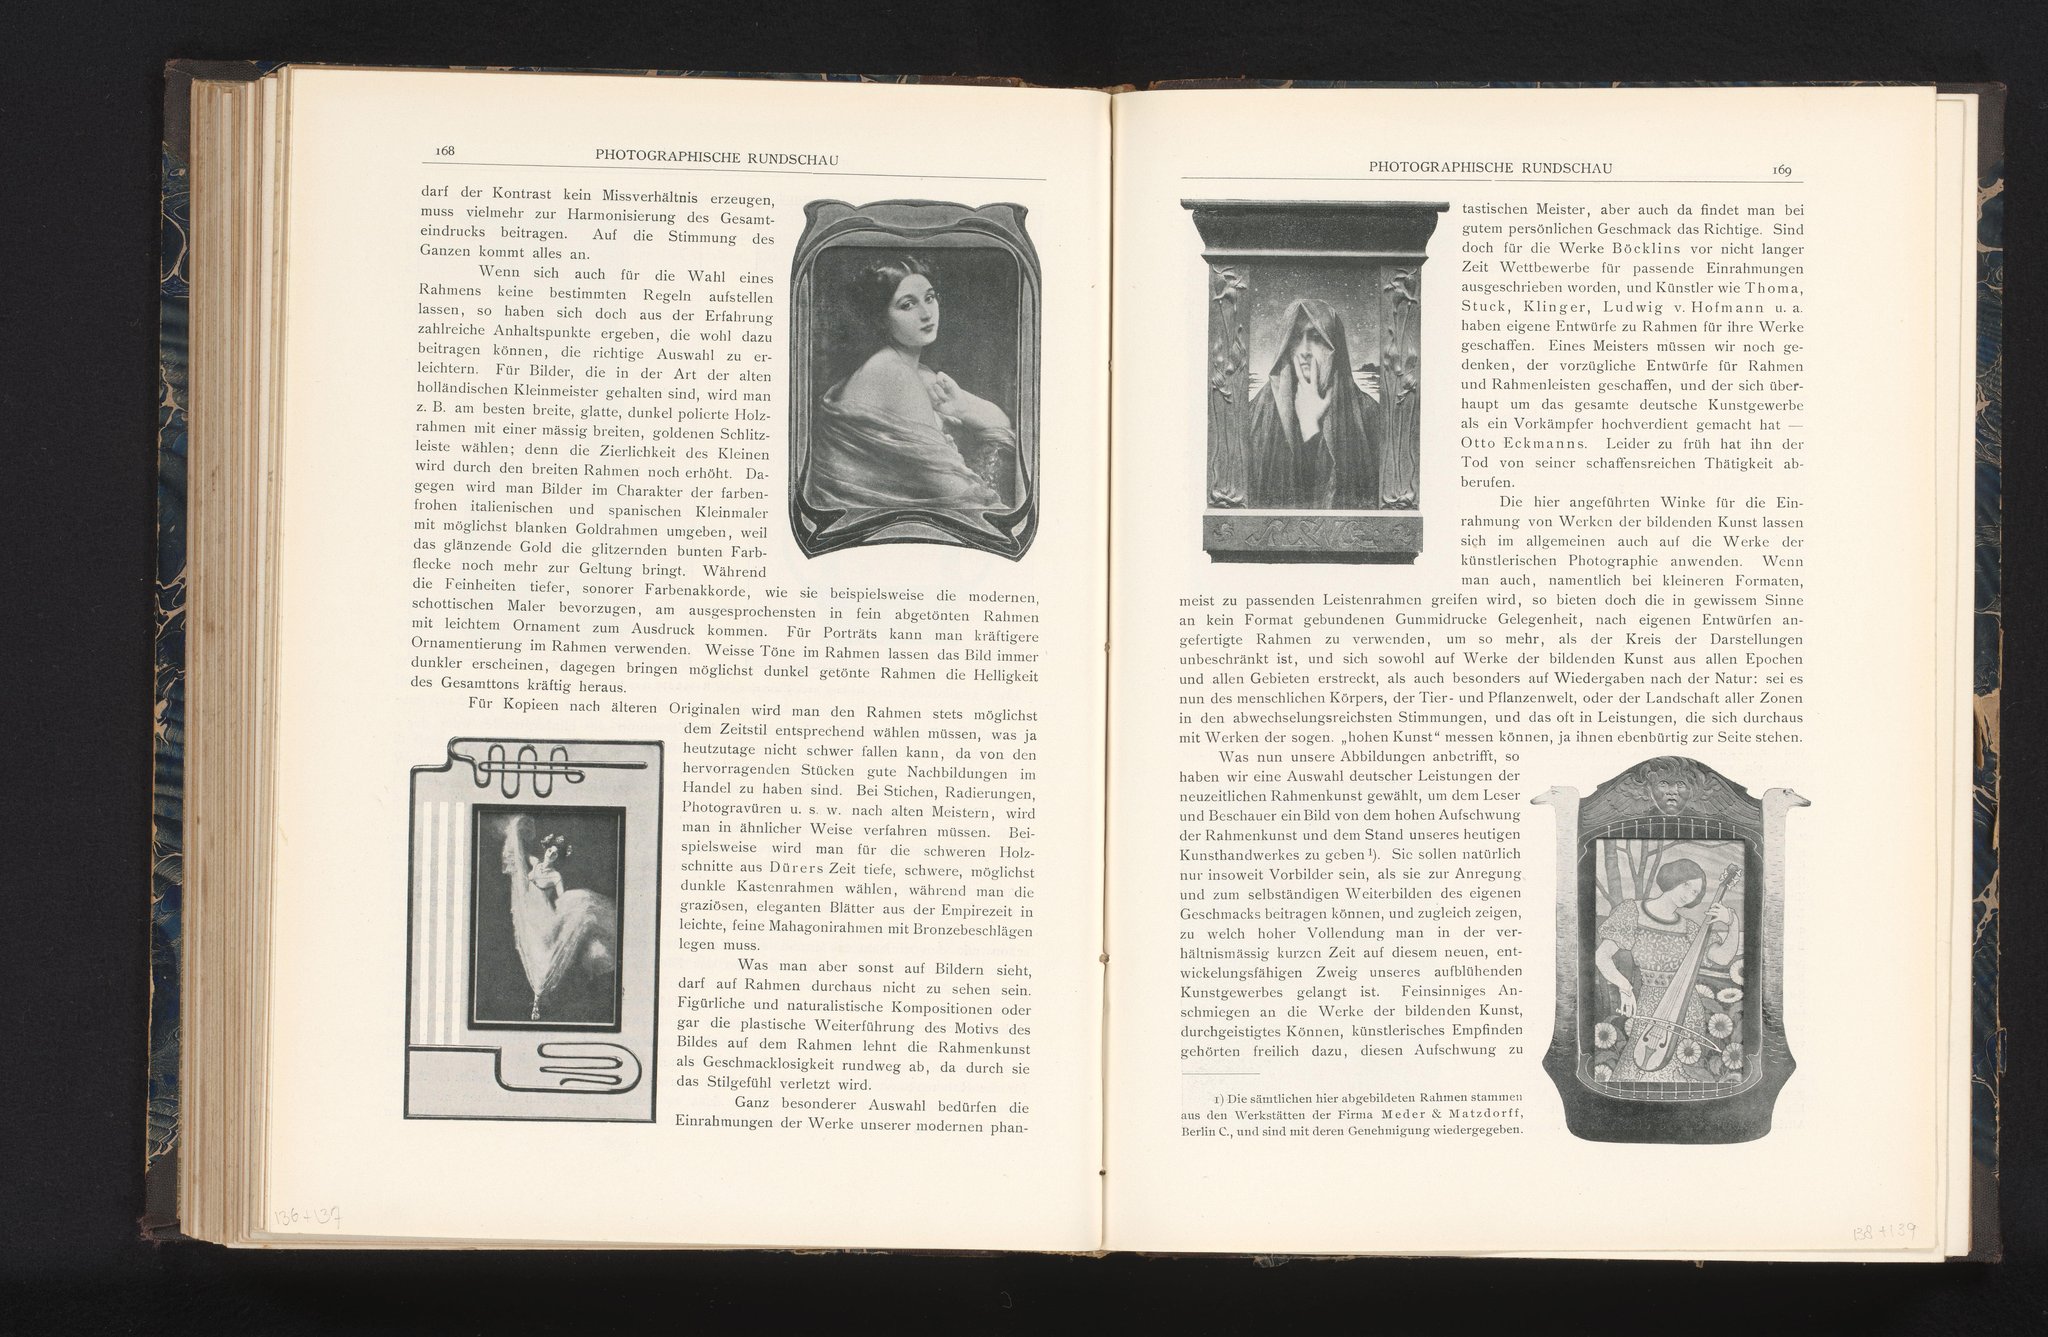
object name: page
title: Gezicht op een lijst met vermoedelijke een tekening van een onbekende vrouw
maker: Anonymous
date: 1897-1902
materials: paper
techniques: autotype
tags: frame of painting, etc.